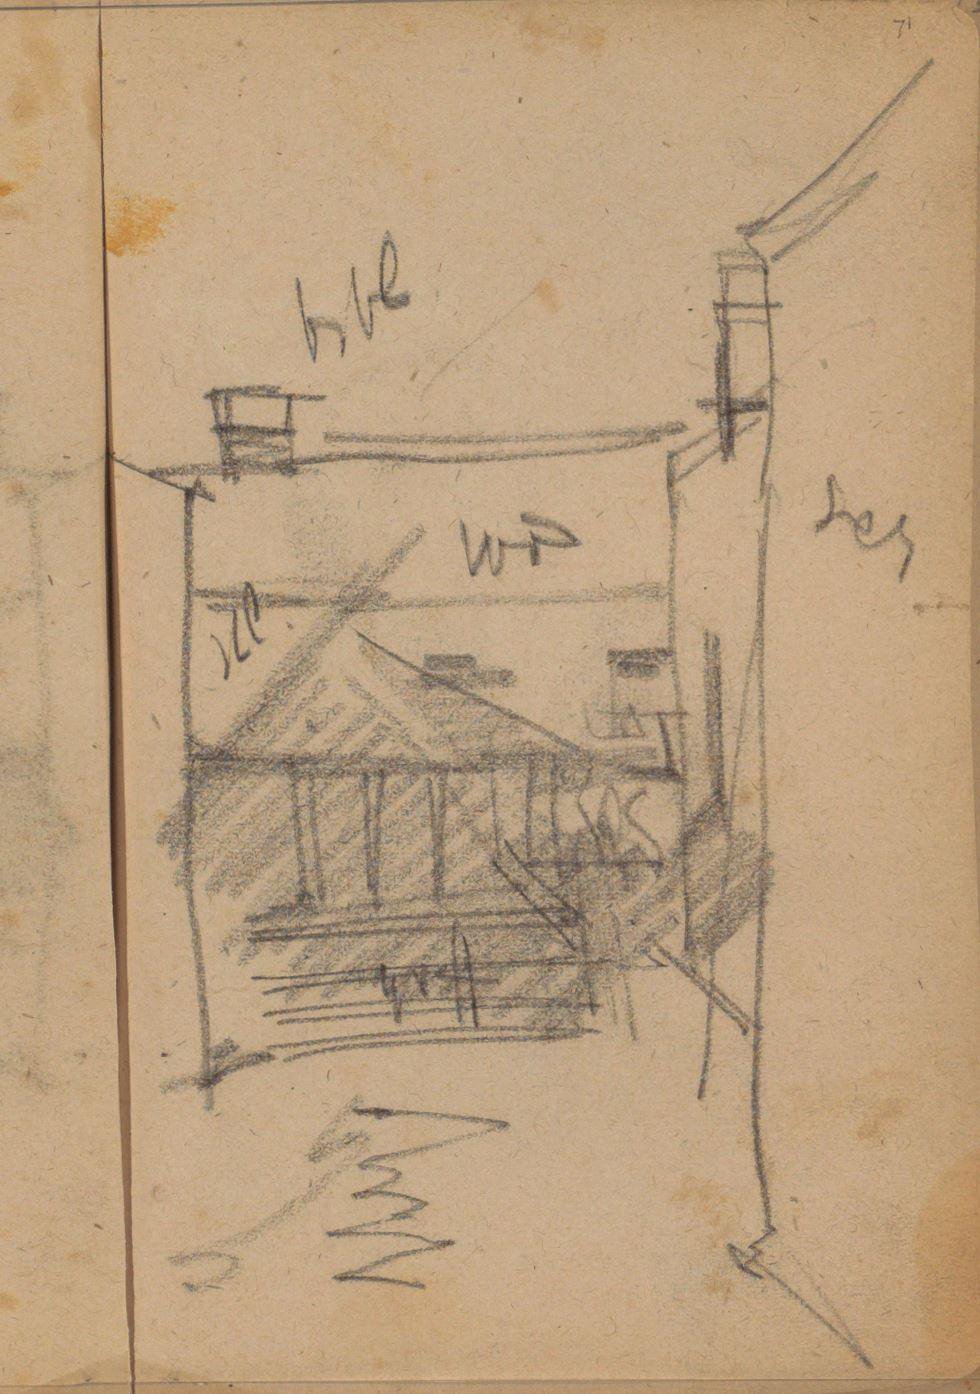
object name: sketchbook leaf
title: Gezicht op gebouwen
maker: george hendrik breitner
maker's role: draughtsman, painter, print maker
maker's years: 1857-1923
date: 1881-1883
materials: chalk, paper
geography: south holland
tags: civic architecture; edifices; dwellings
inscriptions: kleurnotitie, handgeschreven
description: Gezicht op gebouwen. Pagina 71 uit een schetsboek met 70 bladen.